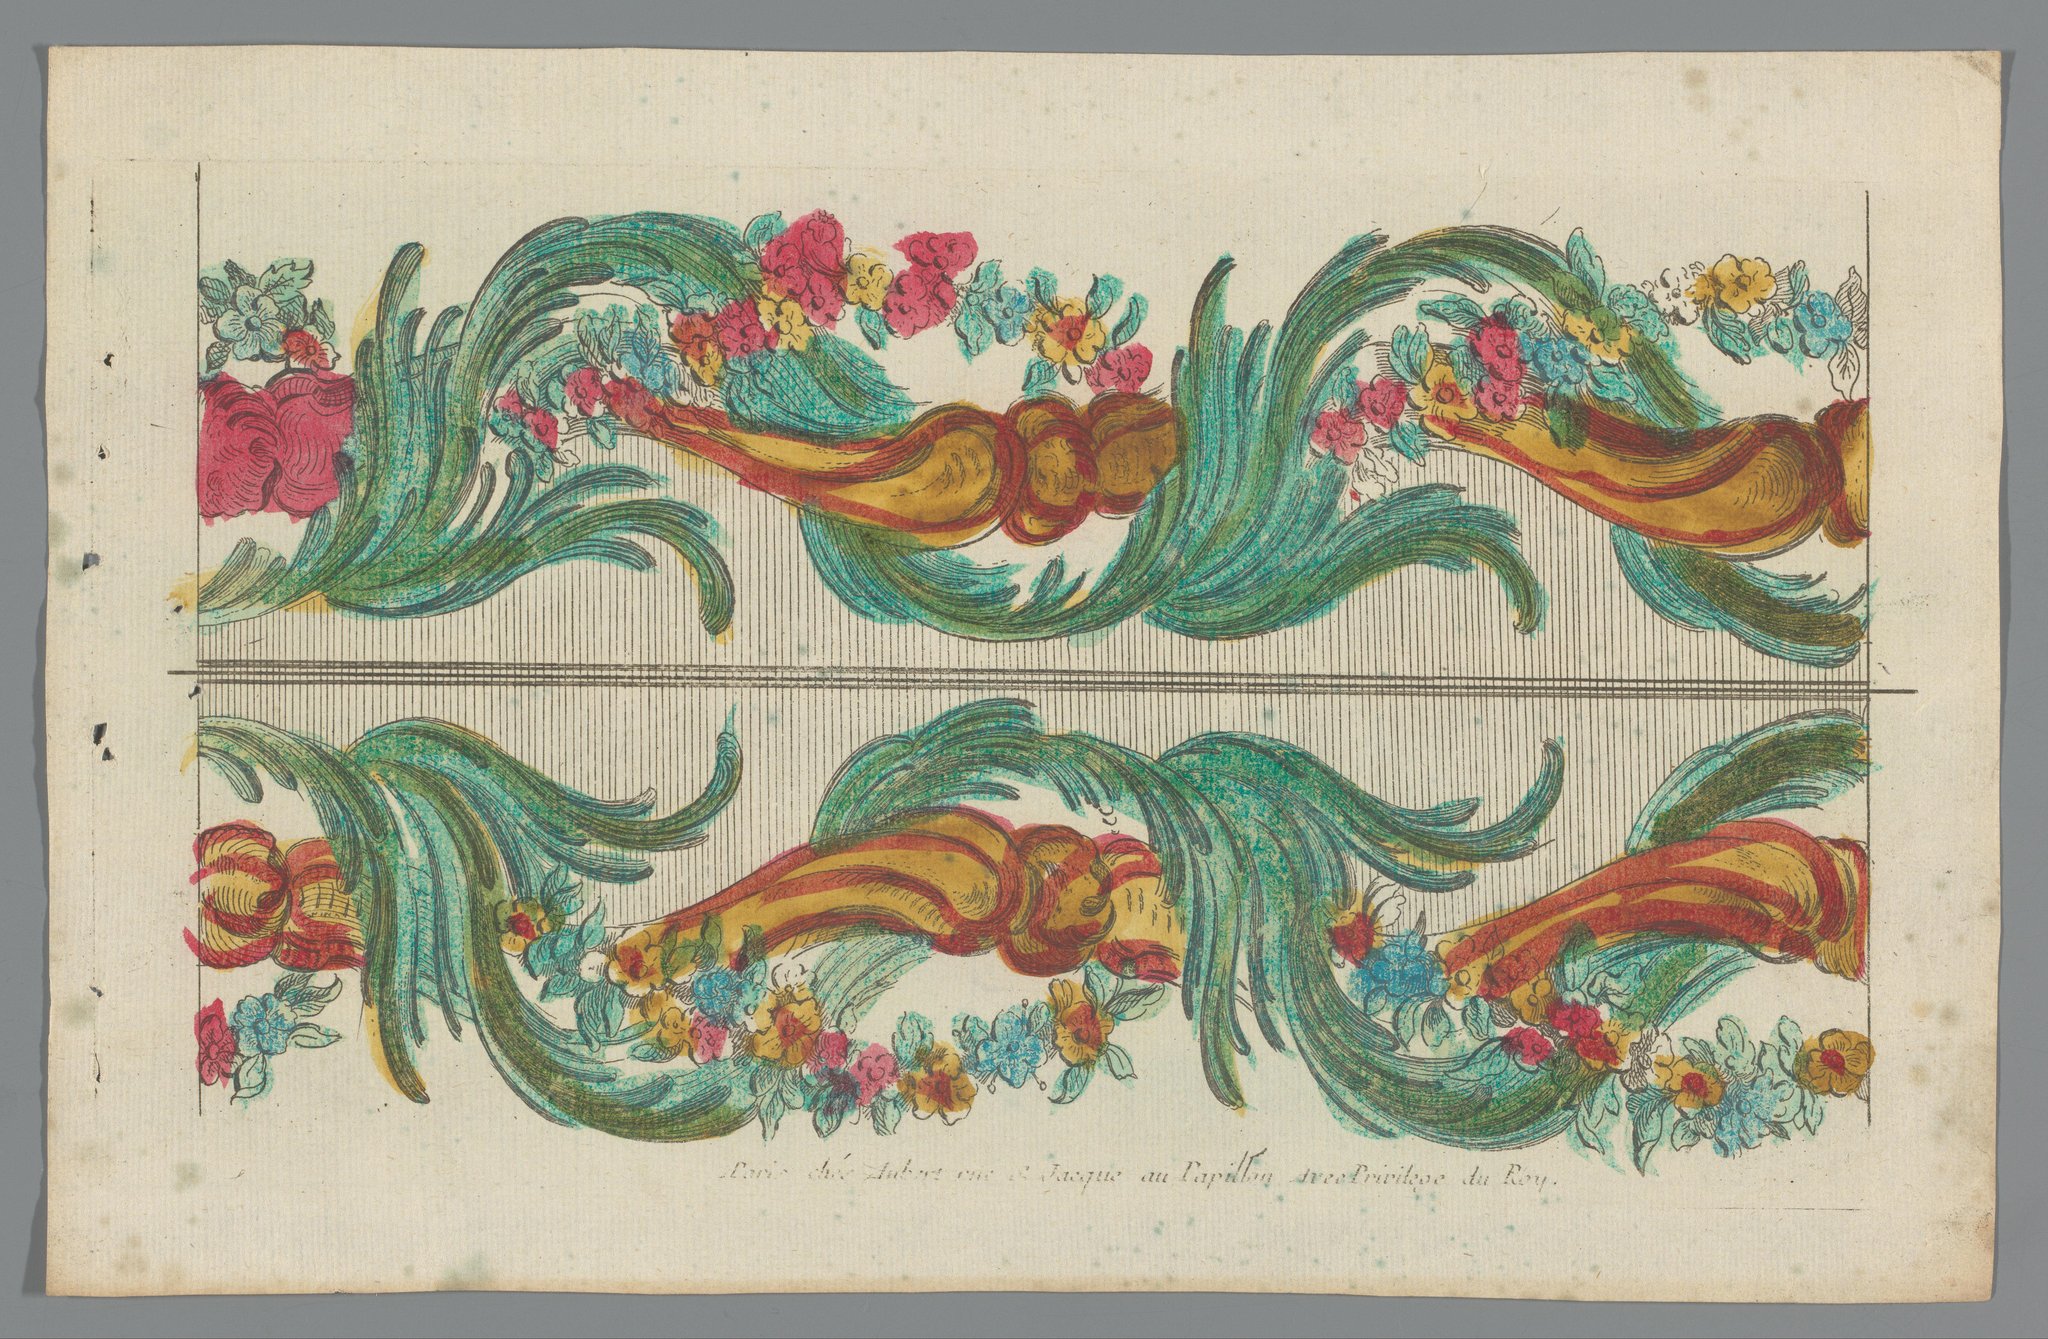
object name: print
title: Bladen met knipplaatjes en decoratieve randen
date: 1750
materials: paper, watercolor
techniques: etching, hand coloring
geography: paris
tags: ornament ~ festoon, garland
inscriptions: collector's mark: Lugt 2228, collector's mark: Lugt 2760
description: Twee bloemenslingers of guirlandes. Een van 39 bladen met knipplaatjes en decoratieve randen.